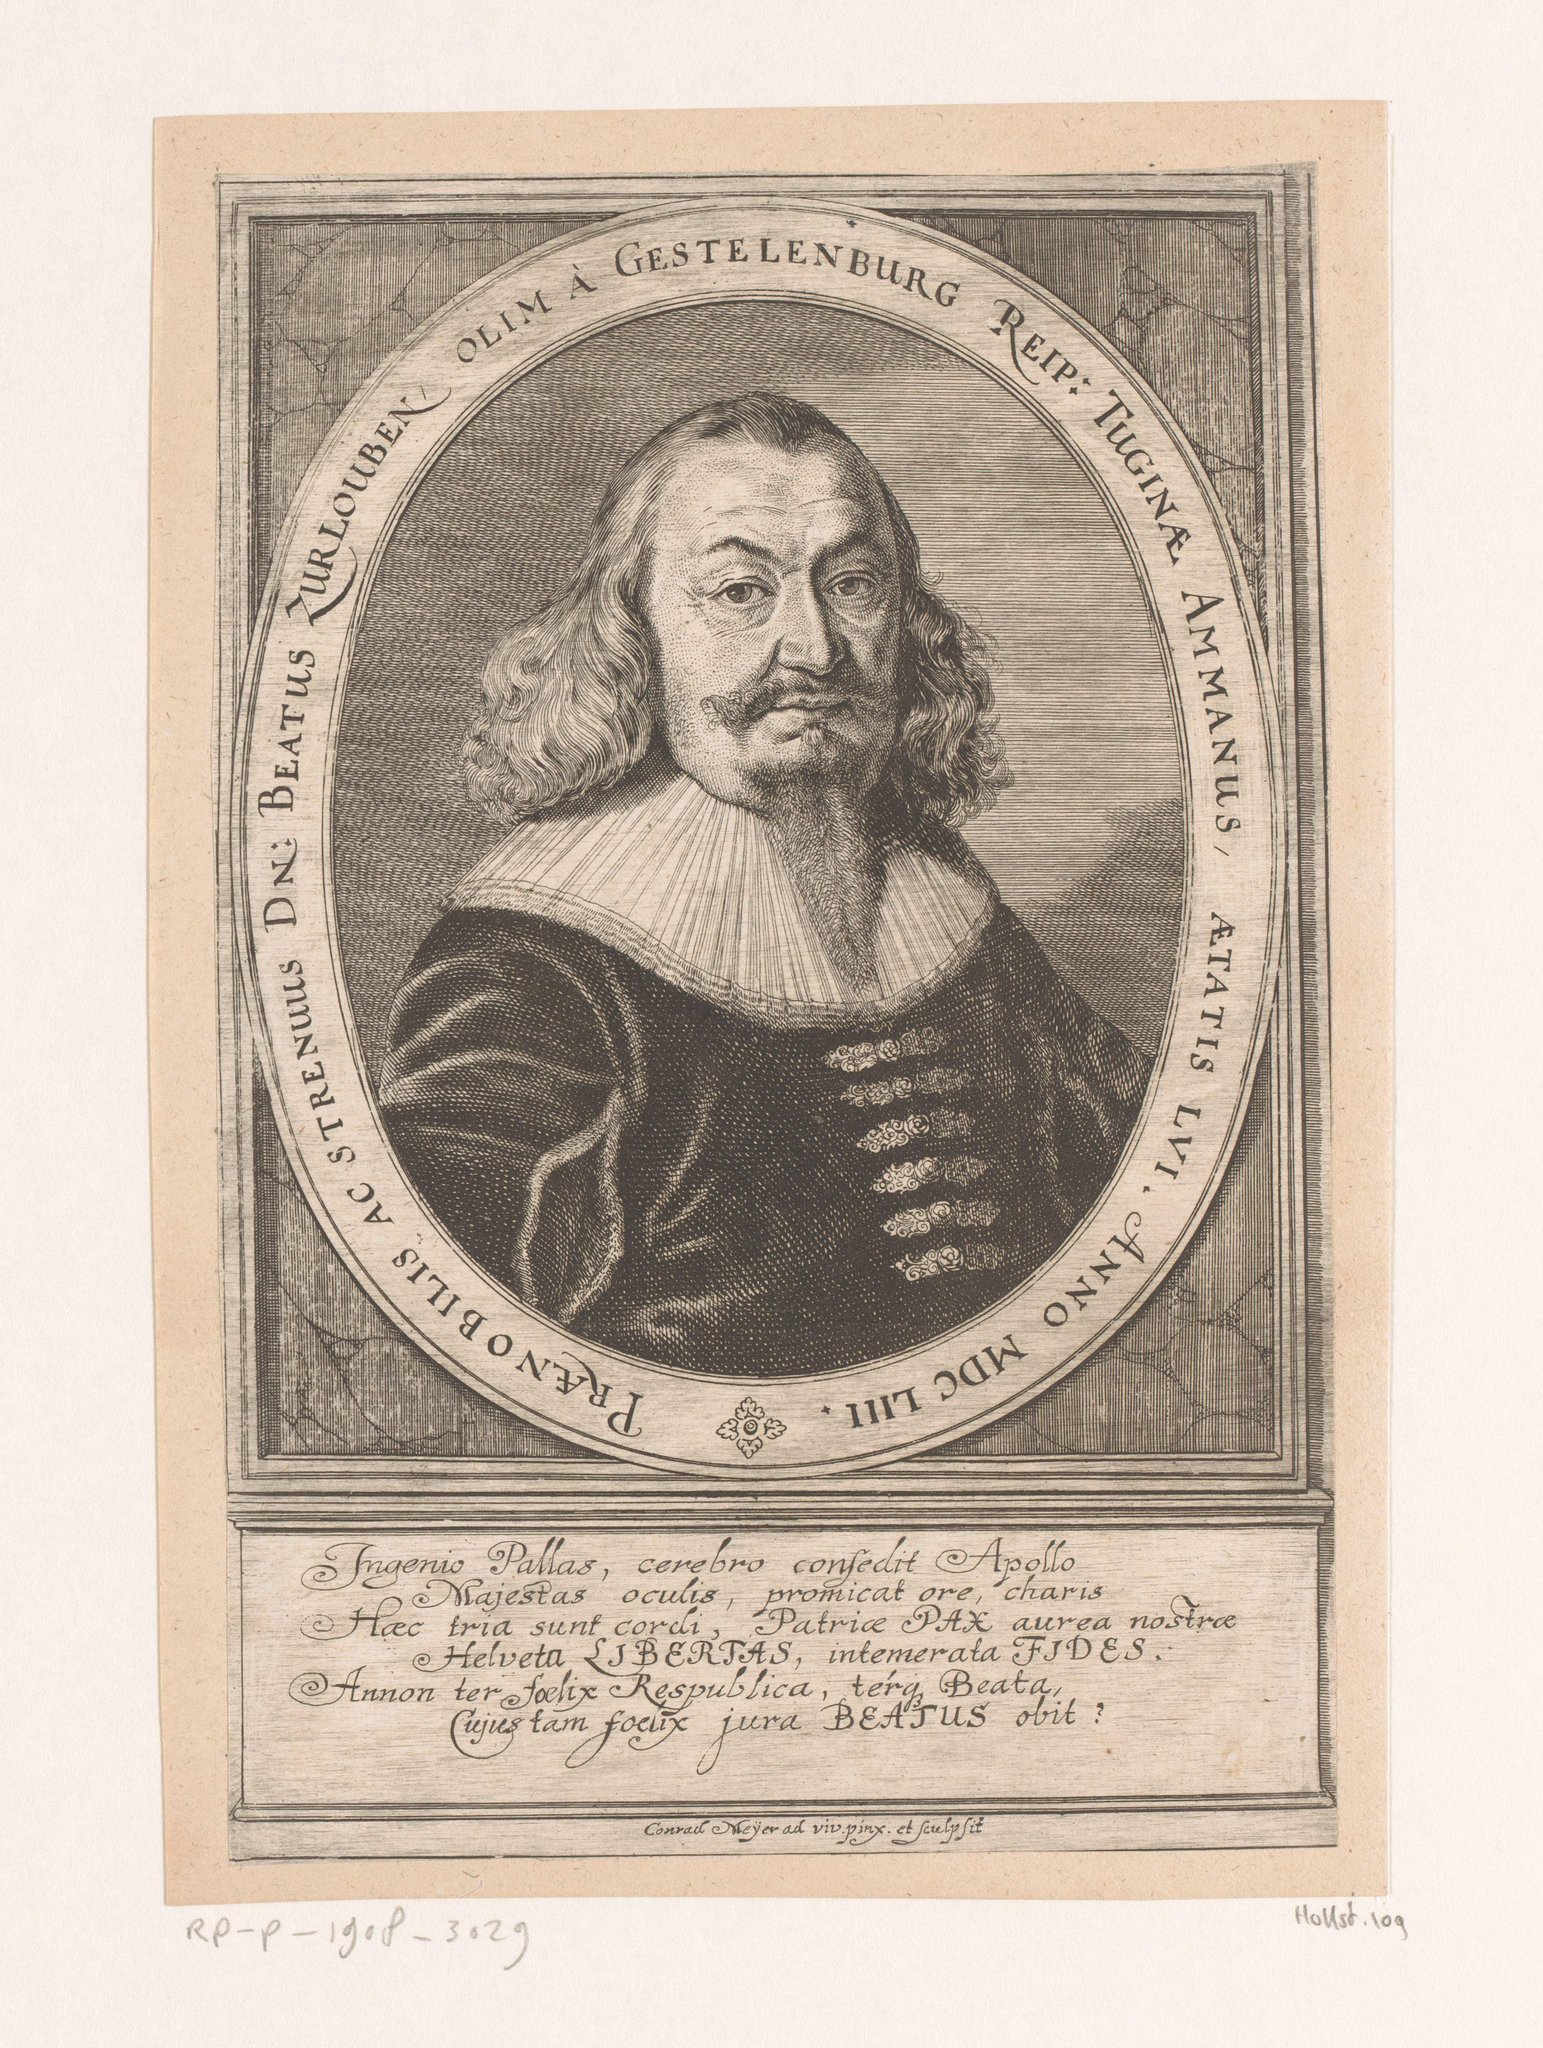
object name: print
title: Portret van Beat Zurlauben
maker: conrad meyer (i)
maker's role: painter, print maker, publisher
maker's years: 1618-1689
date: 1628-1689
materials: paper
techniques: engraving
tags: mayor, historical persons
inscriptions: collector's mark: Lugt 2228